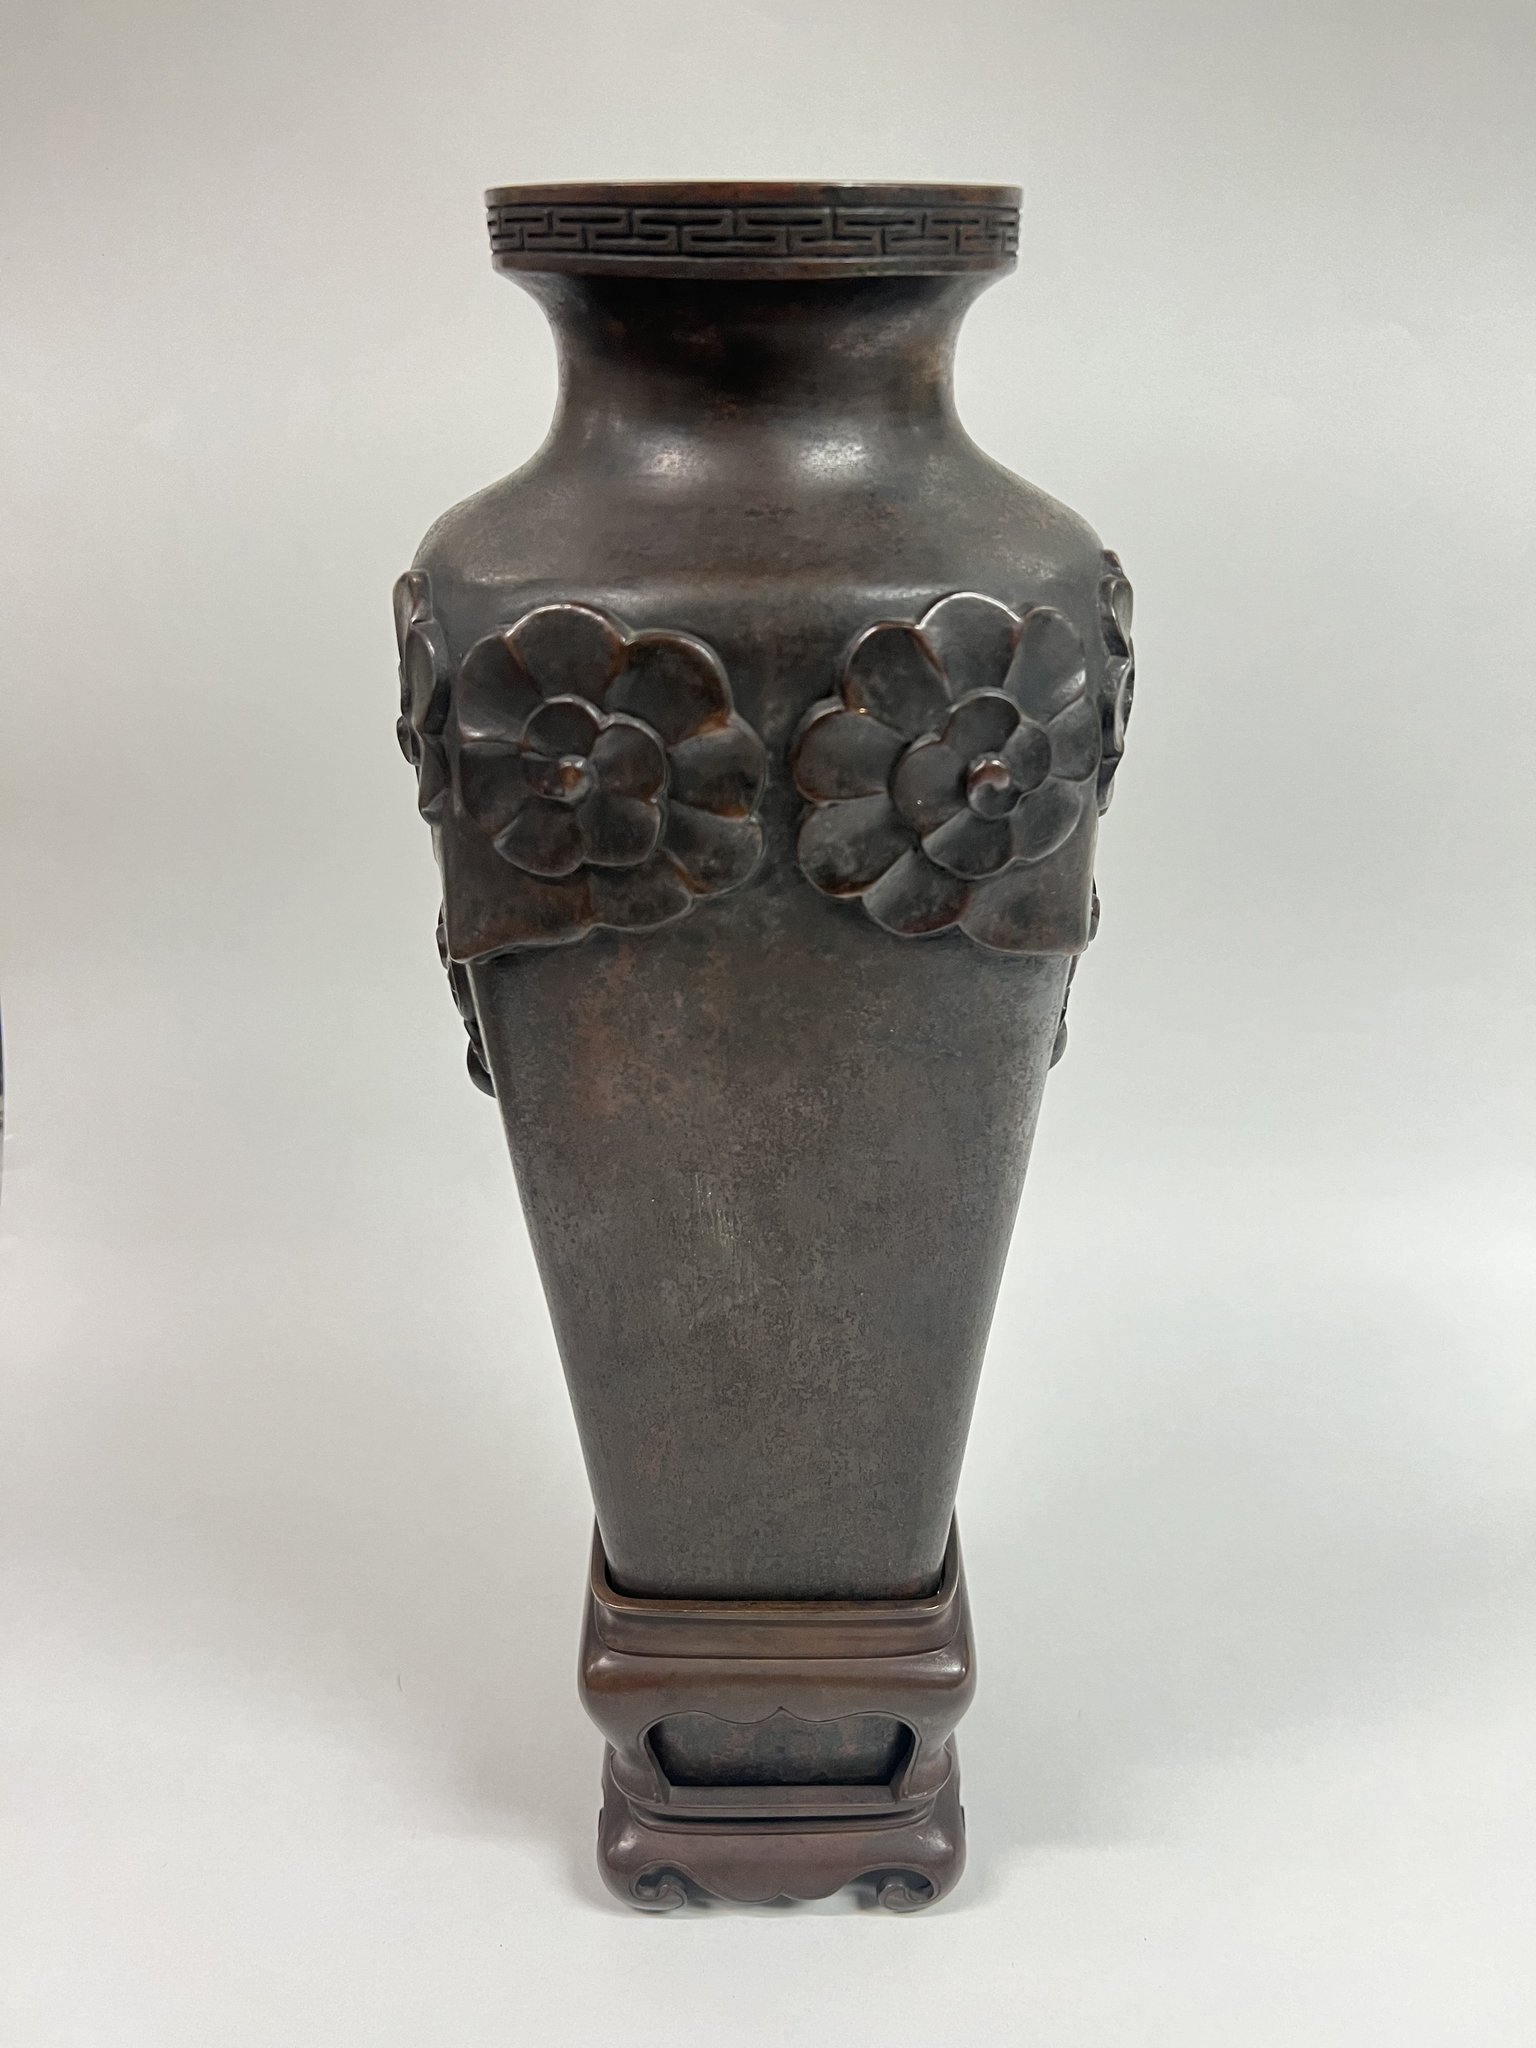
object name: vase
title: Vase in stand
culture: japanese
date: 1801-1900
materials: bronze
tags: flowers